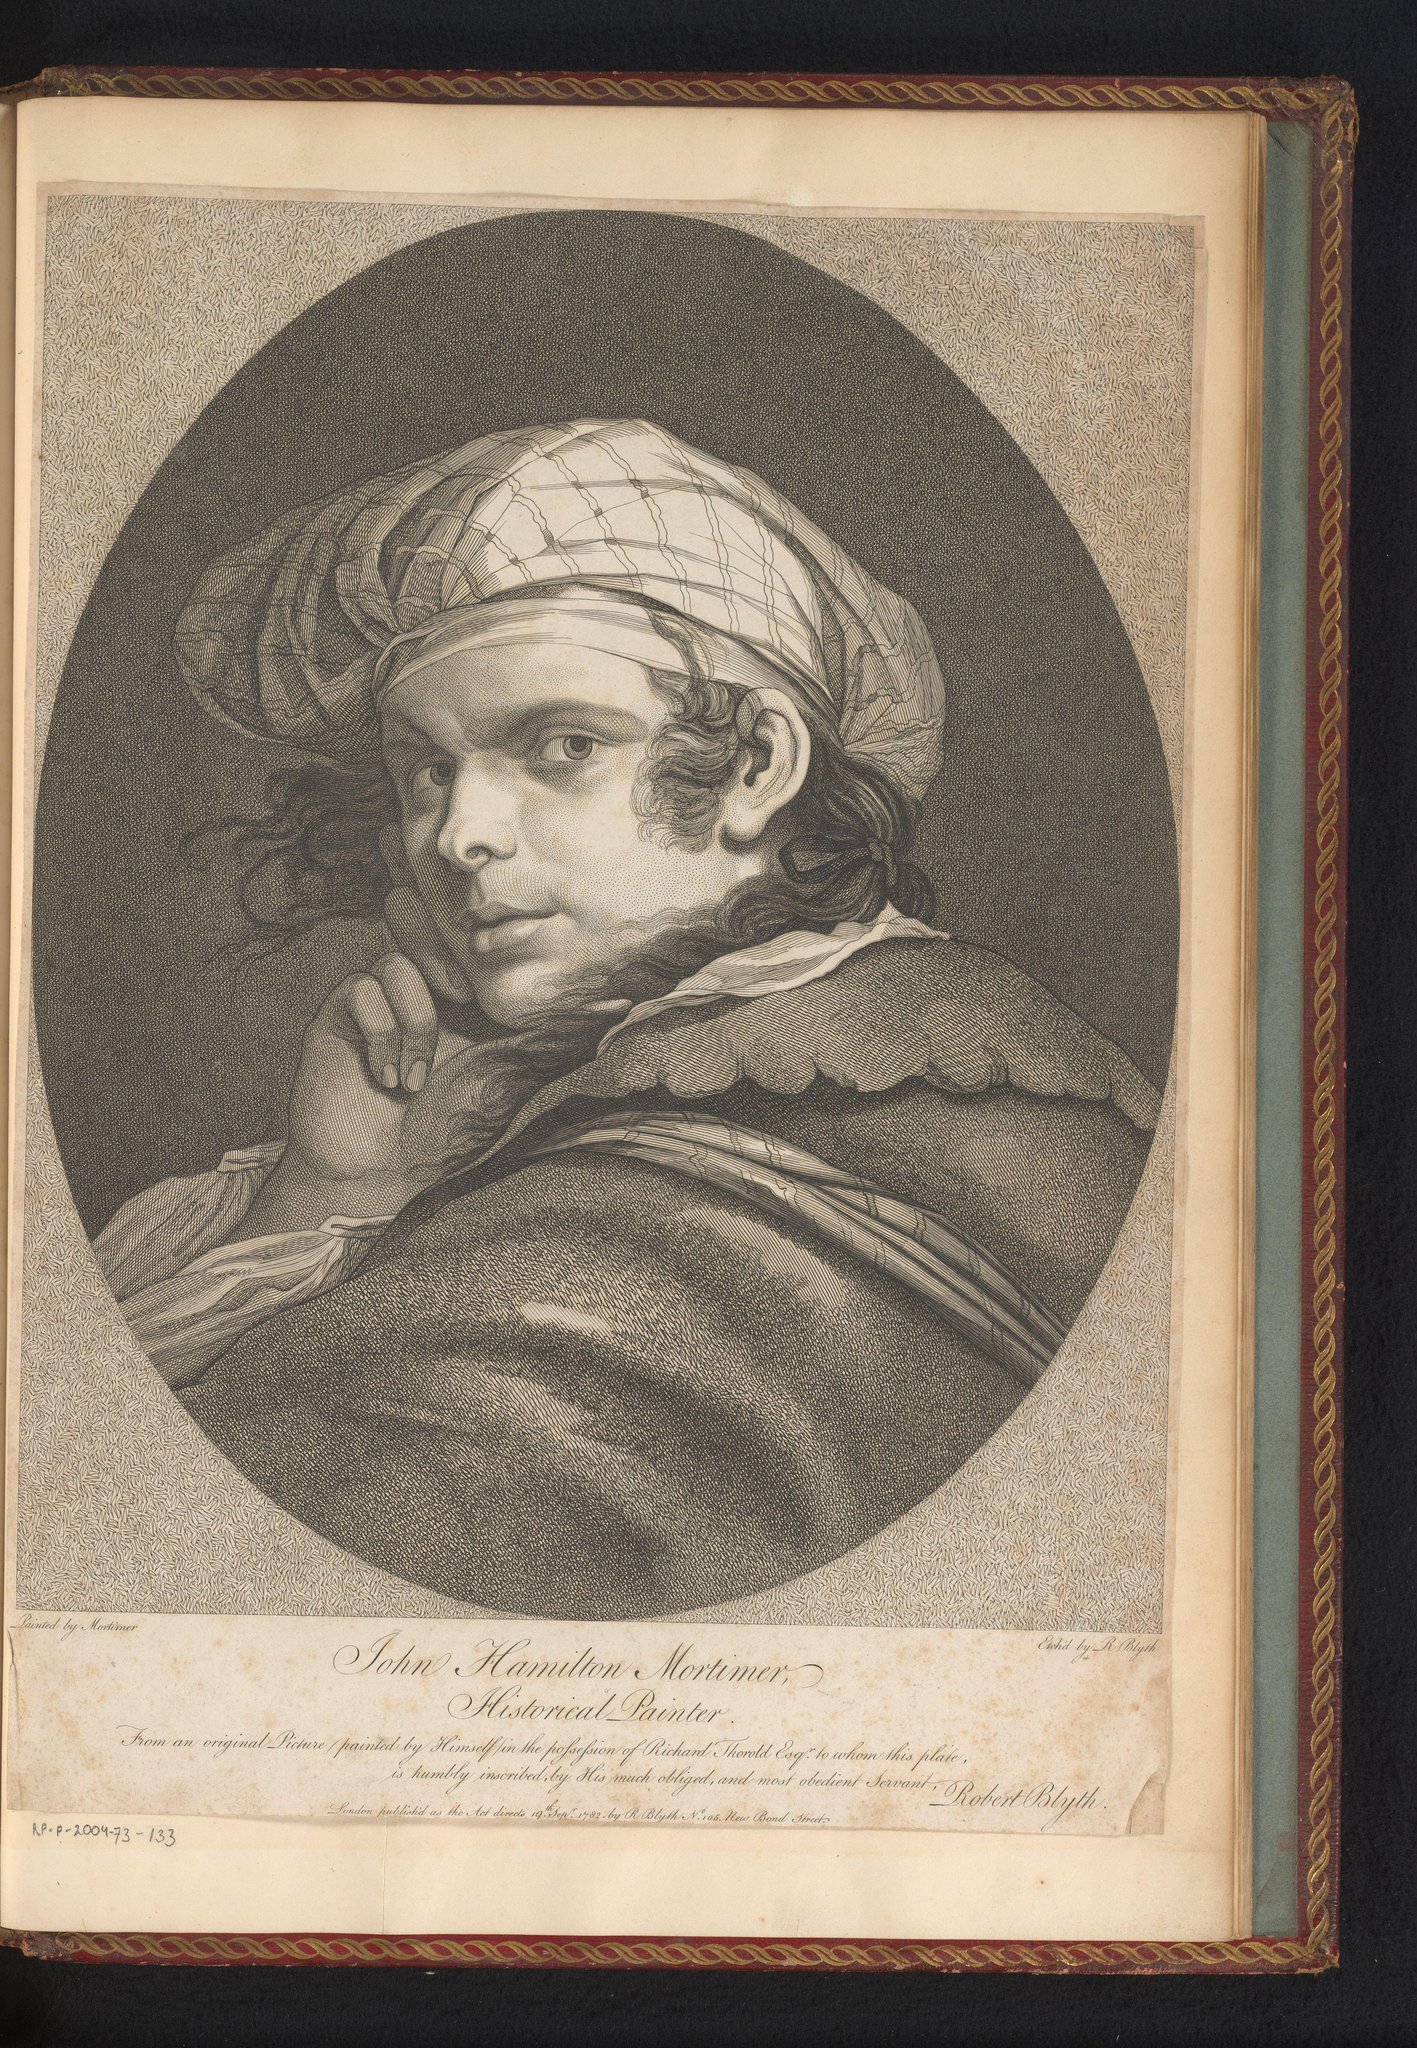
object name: album leaf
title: Portret van John Hamilton Mortimer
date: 1782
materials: paper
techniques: engraving, etching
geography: london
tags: print maker, john hamilton mortimer, historical persons, portrait, self-portrait of painter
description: De samensteller heeft deze prent in het album geplakt als illustratie bij: Pilkington, Matthew en Johann Heinrich Füssli. A dictionary of painters, from the revival of the art to the present period. 4 dln. Londen: John Crowder, 1805, dl. 2, p. 350.